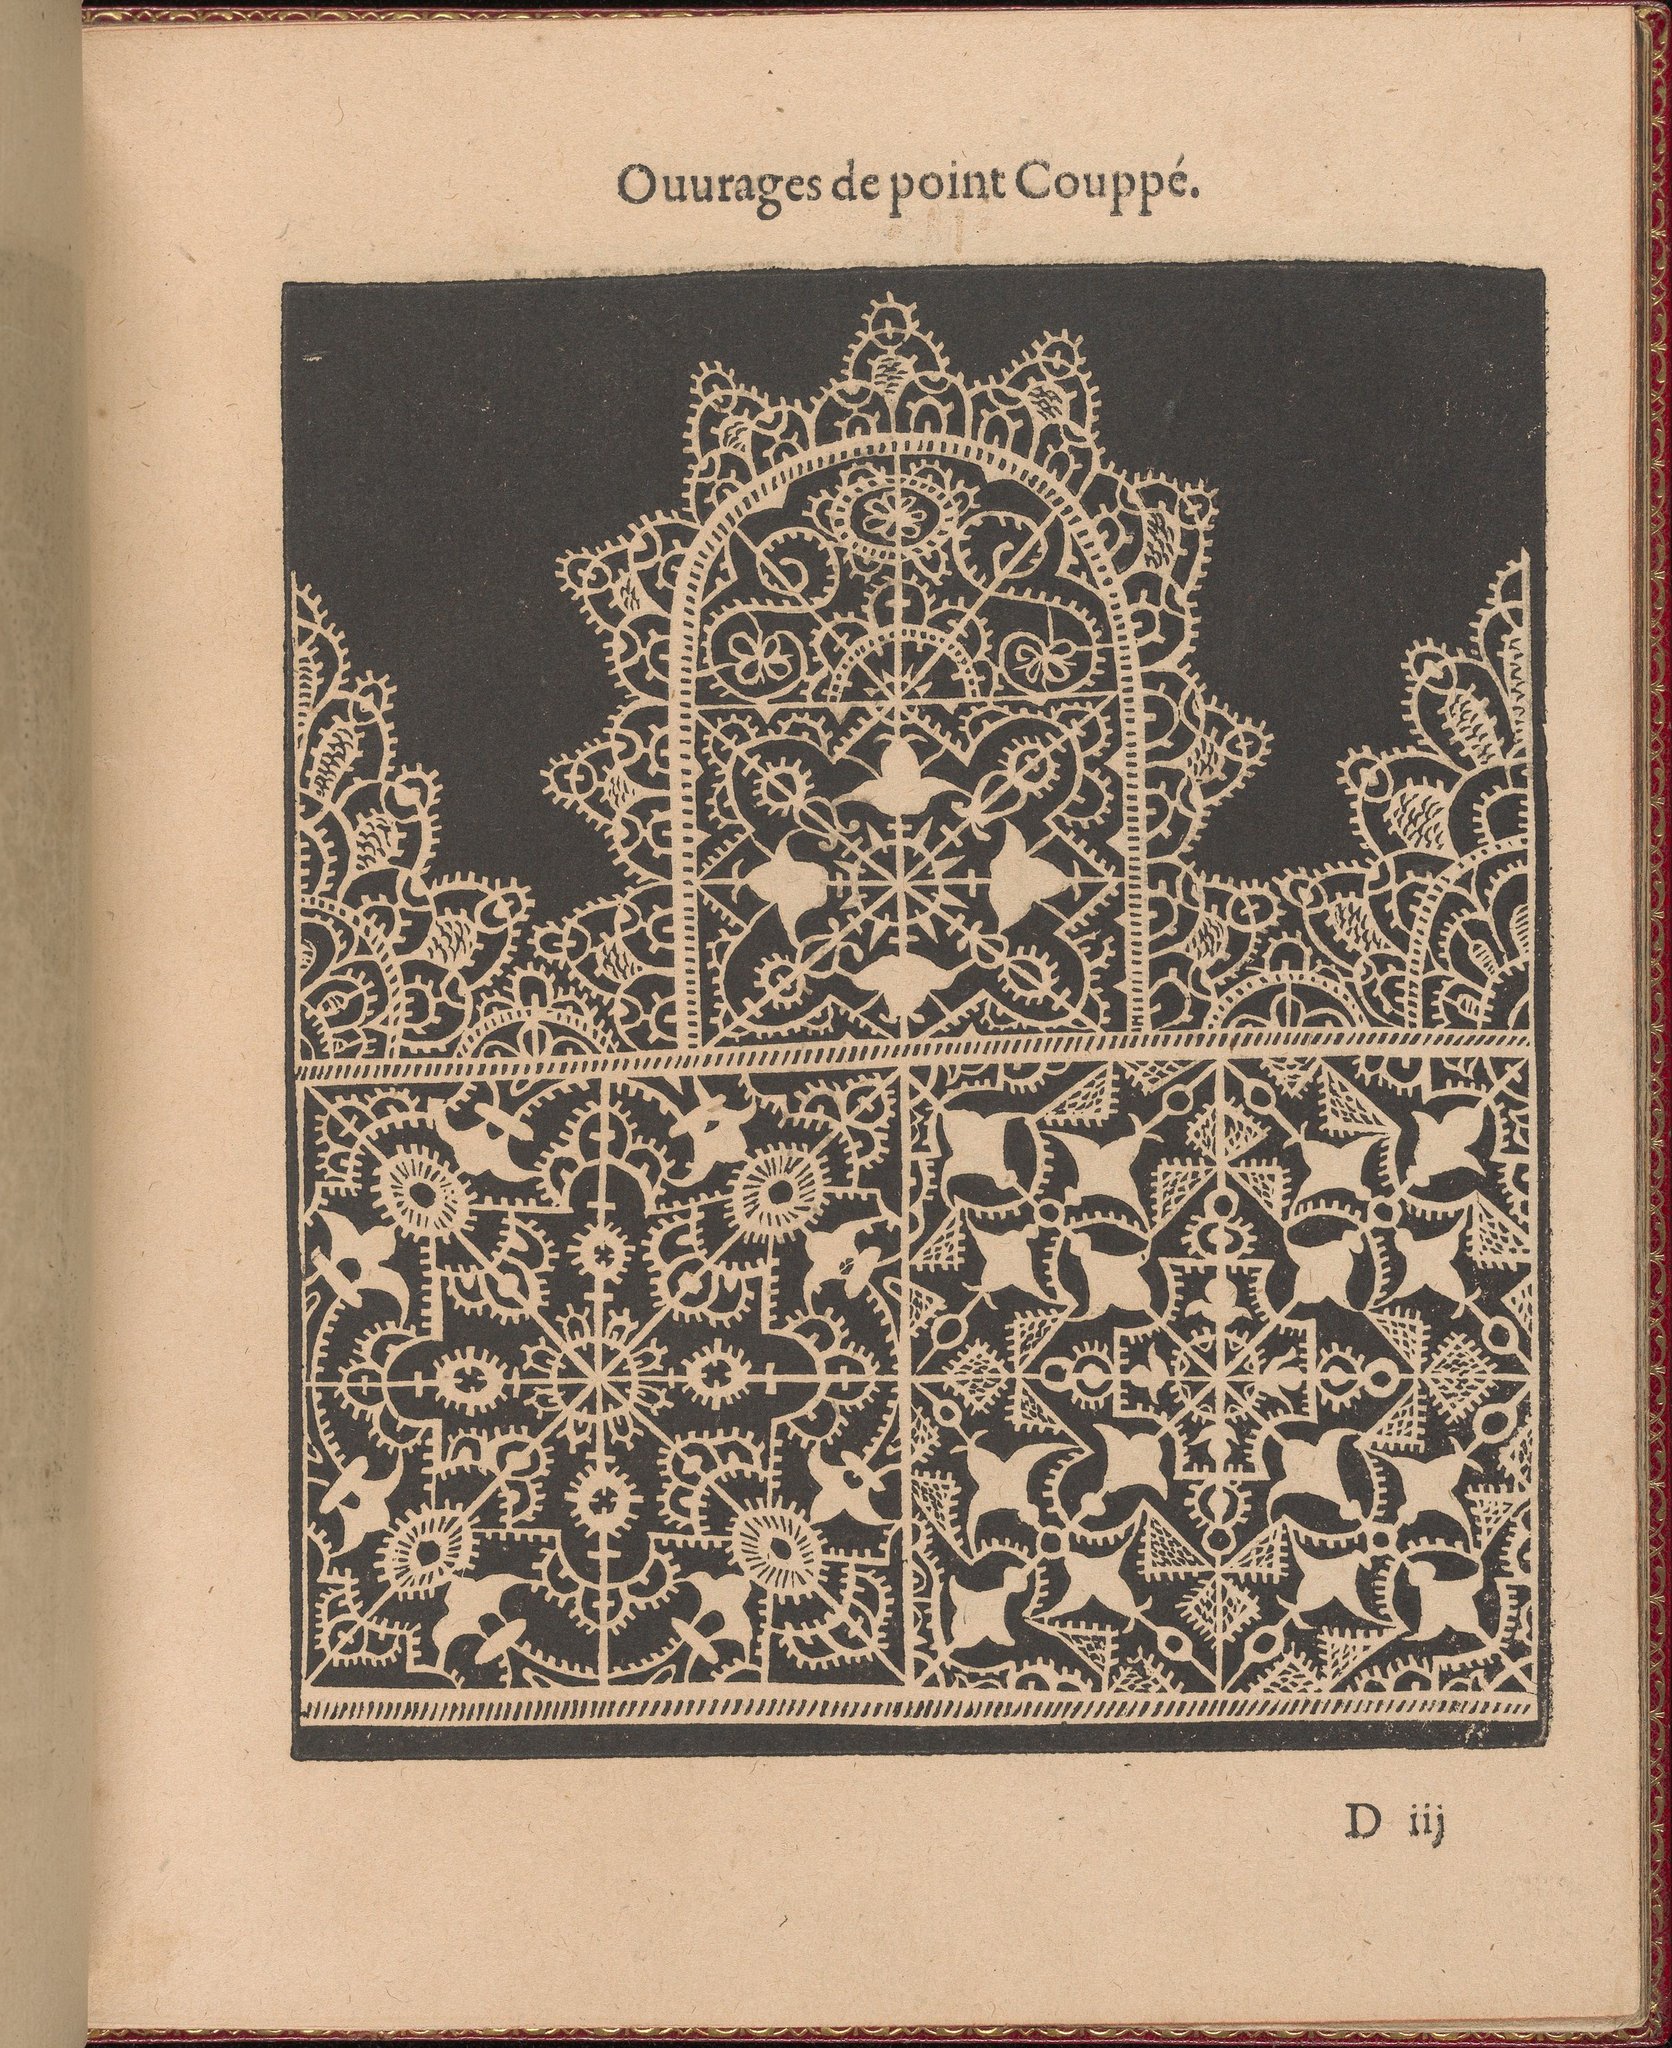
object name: book print ornament architecture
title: Les Singuliers et Nouveaux Portraicts... page 15 (recto)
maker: federico de vinciolo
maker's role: designer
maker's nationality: italian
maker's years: 1582-1599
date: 1588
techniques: woodcut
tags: ornament